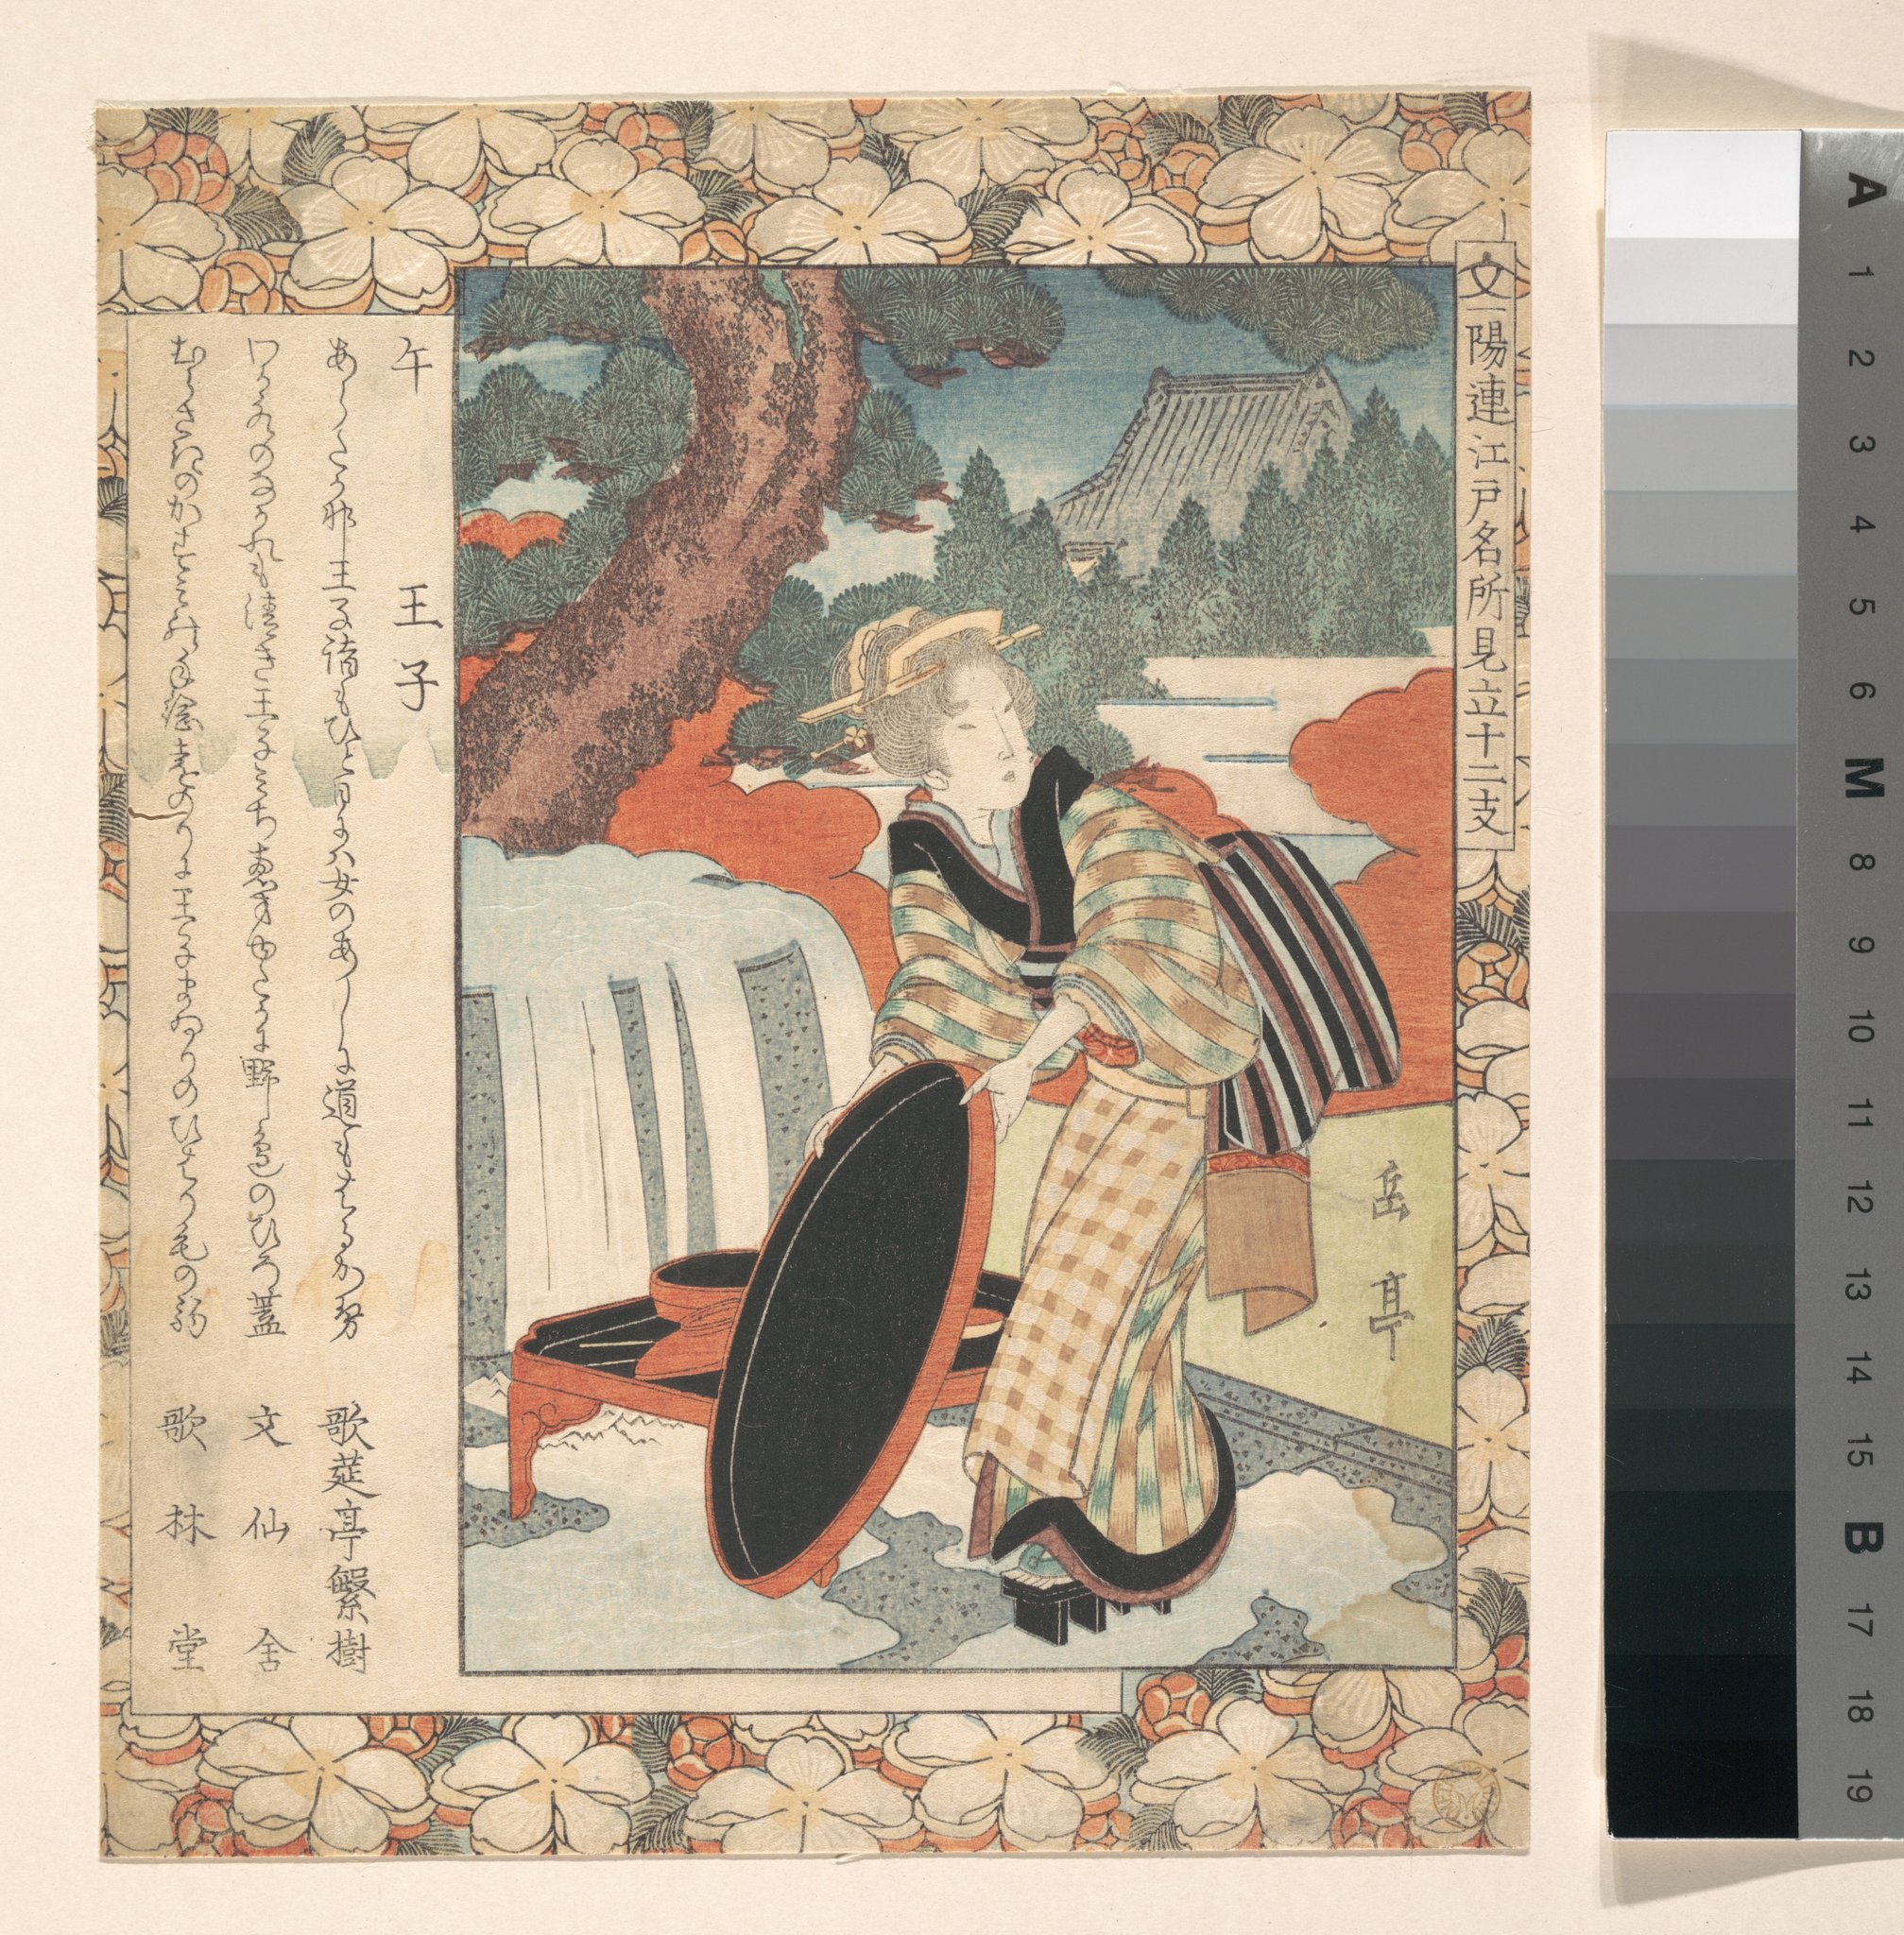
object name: print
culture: japanese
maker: yashima gakutei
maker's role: artist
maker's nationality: japanese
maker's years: 1786-1868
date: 1830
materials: ink, paper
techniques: surimono, woodblock print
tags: women,waterfalls,washing